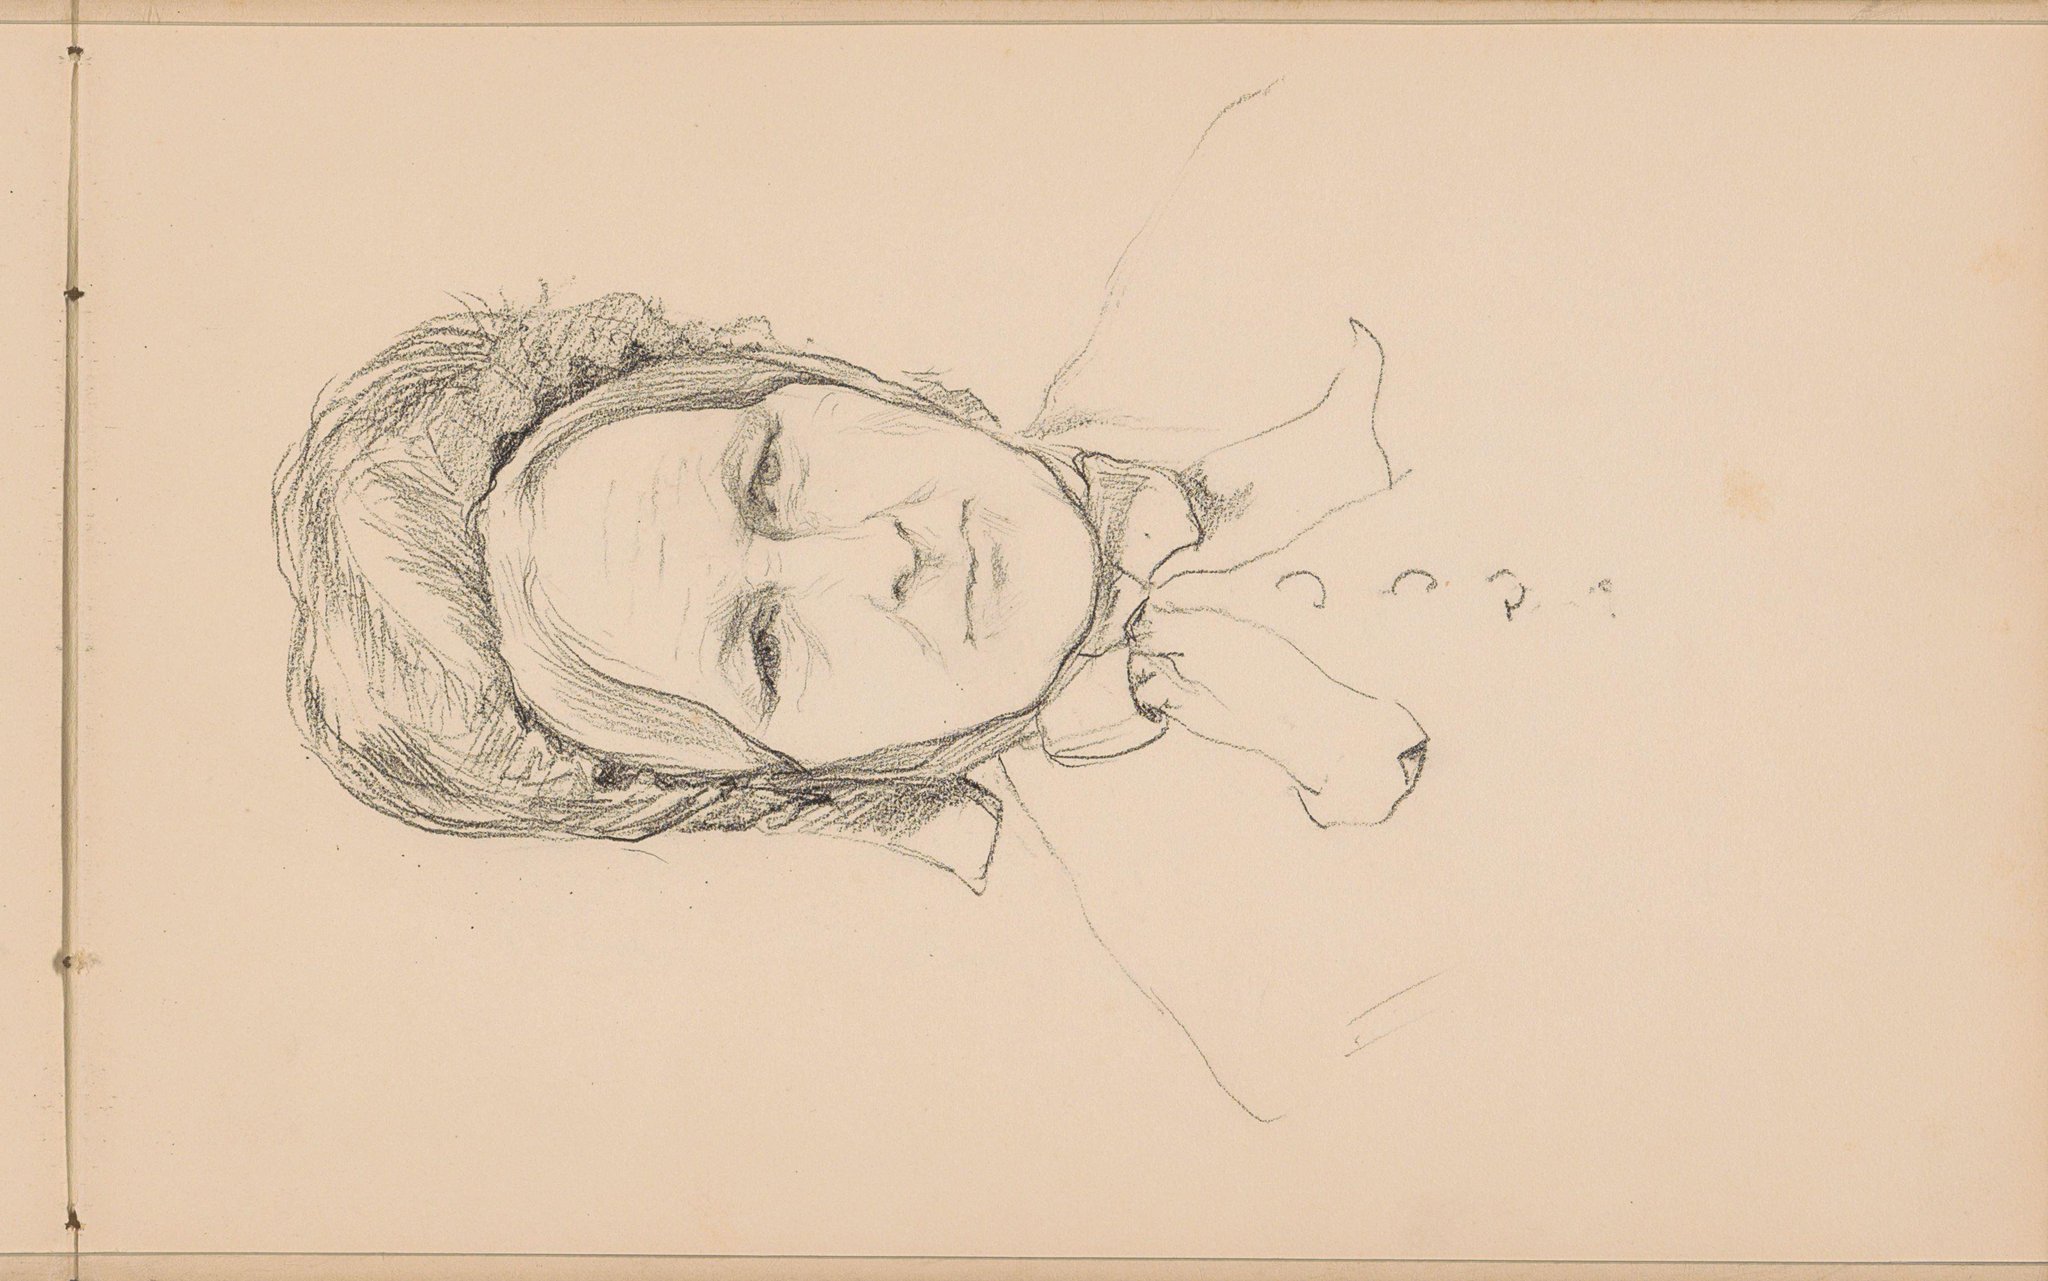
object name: sketchbook leaf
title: Kop van een oudere vrouw met een onder de kin gestrikte muts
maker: a.a.l. de grammont-hubrecht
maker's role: draughtsman, painter, print maker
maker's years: 1855-1913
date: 1865-1913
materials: chalk, paper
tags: head-gear: cap (+ women's clothes), old woman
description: Blad 20 recto uit een schetsboek met 65 bladen.